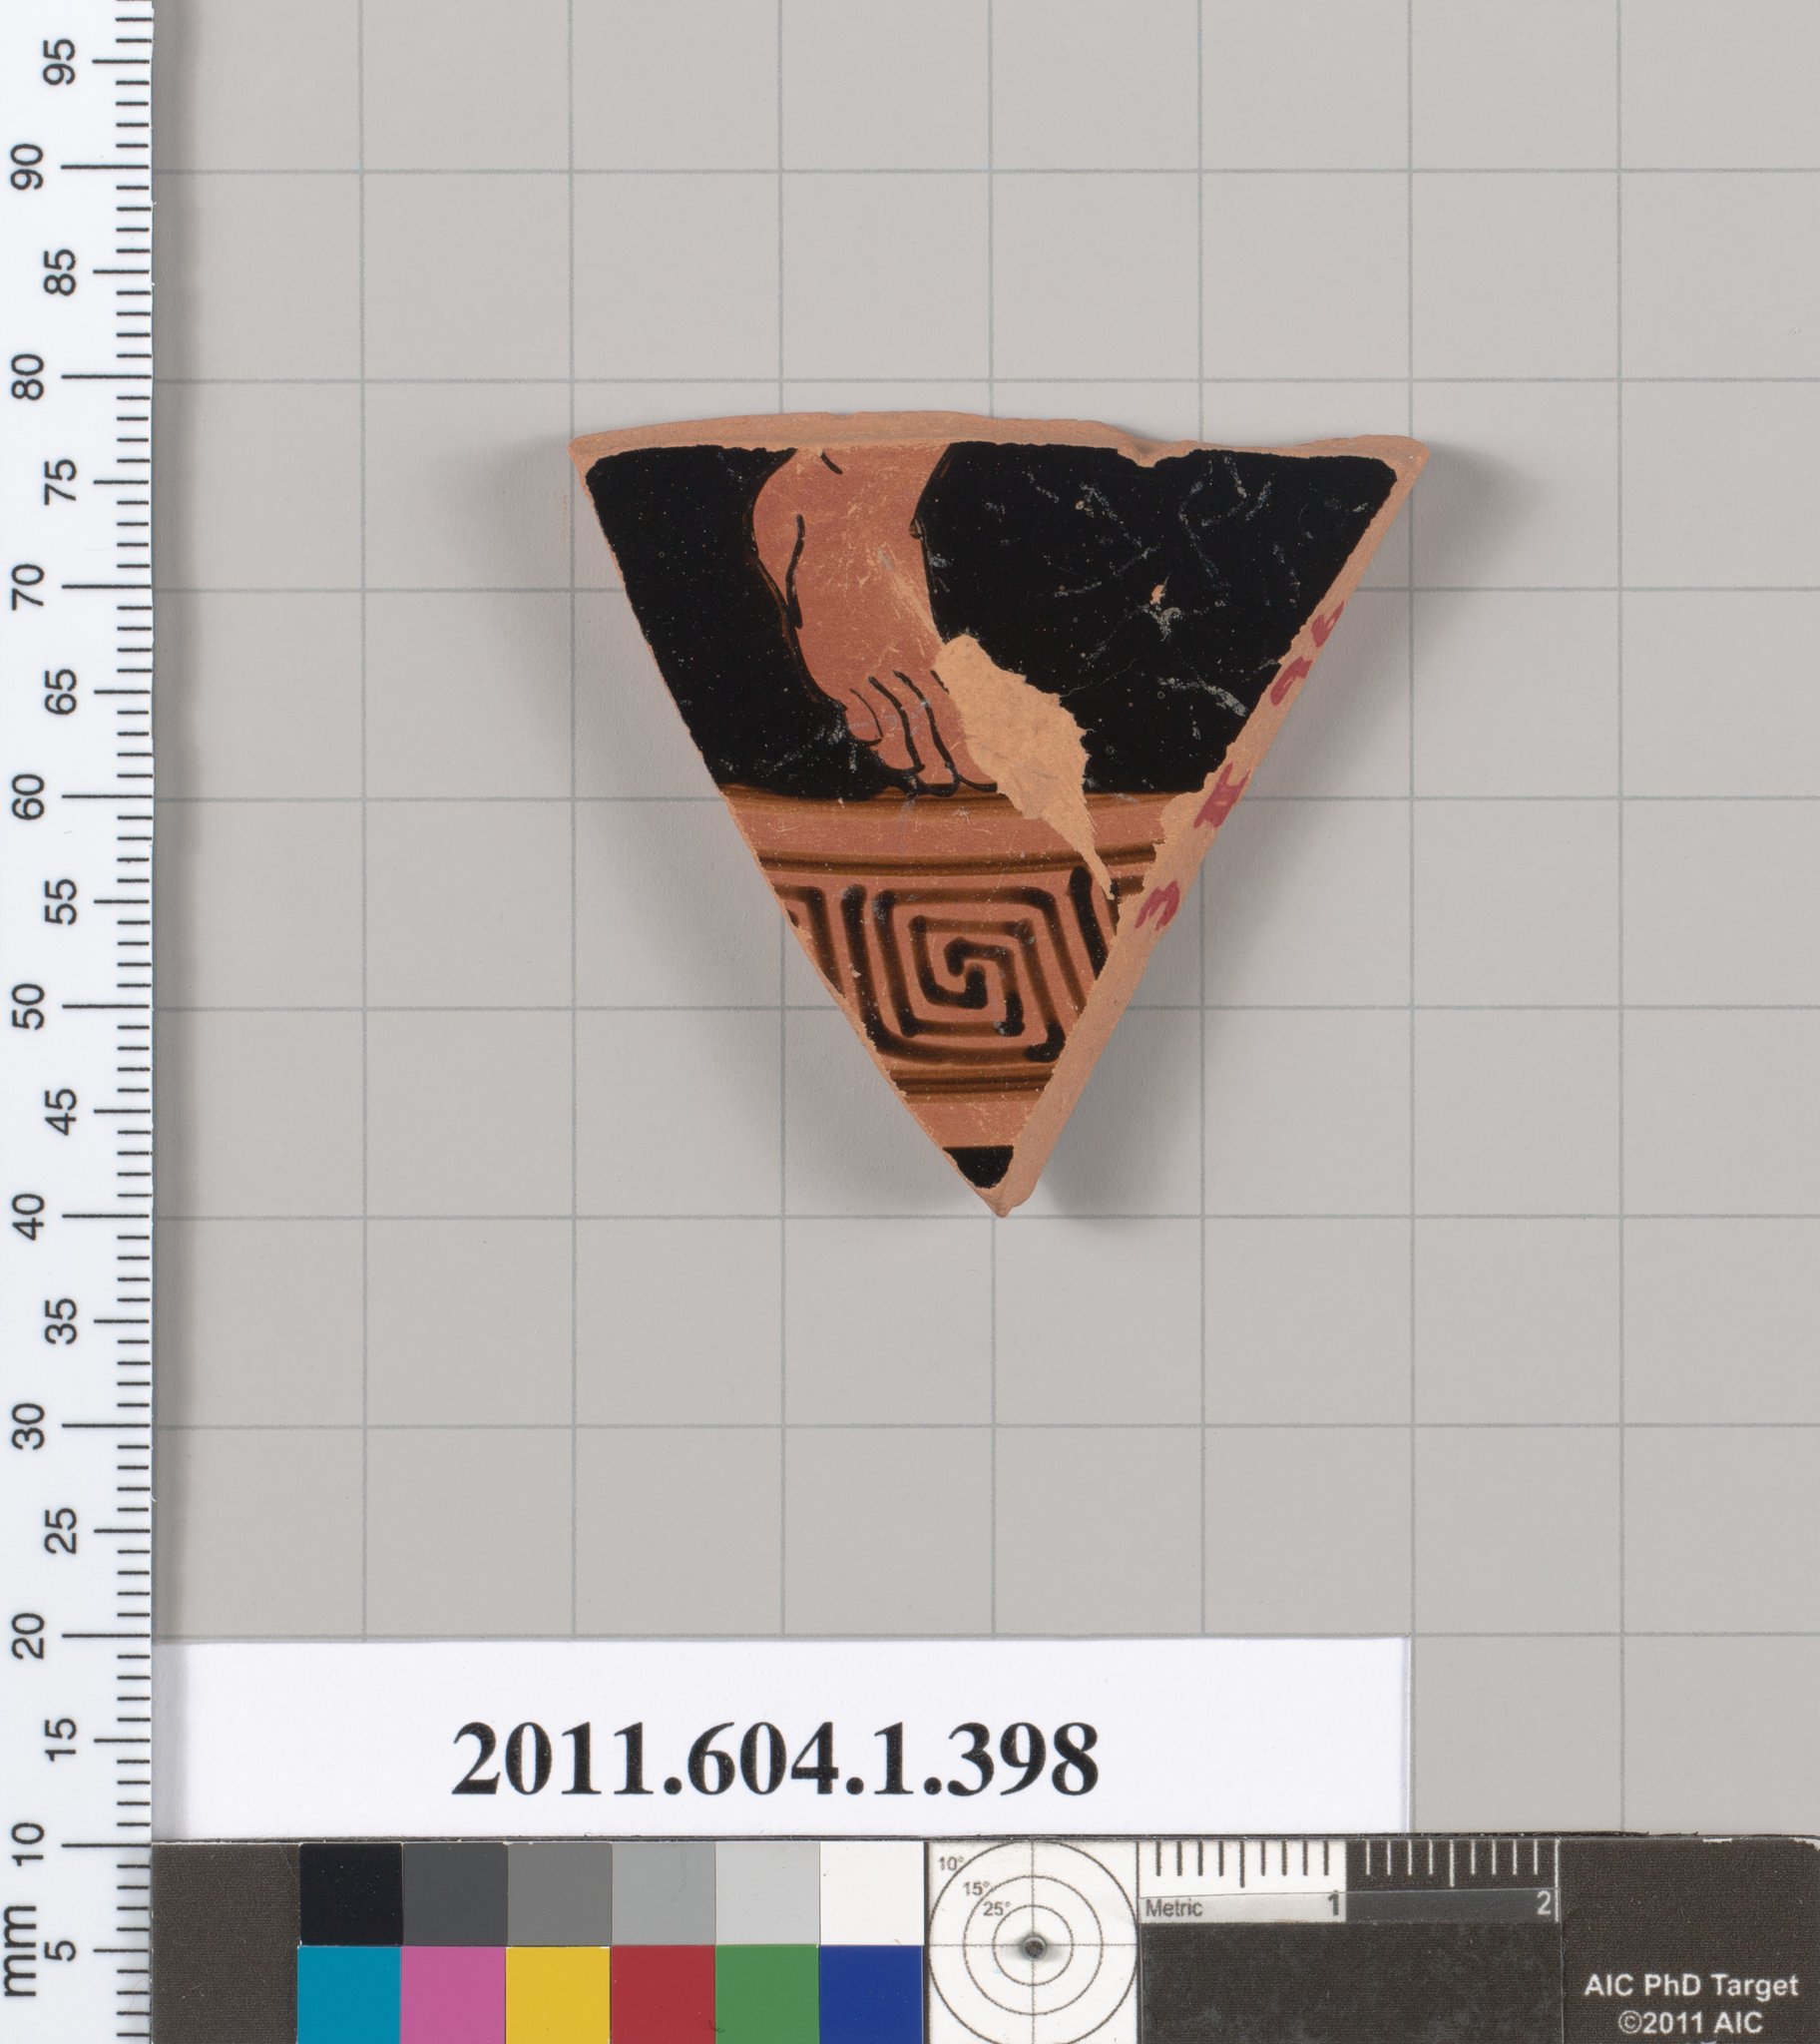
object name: kylix fragment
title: Terracotta fragment of a kylix (drinking cup)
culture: greek, attic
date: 475-451 BCE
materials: terracotta